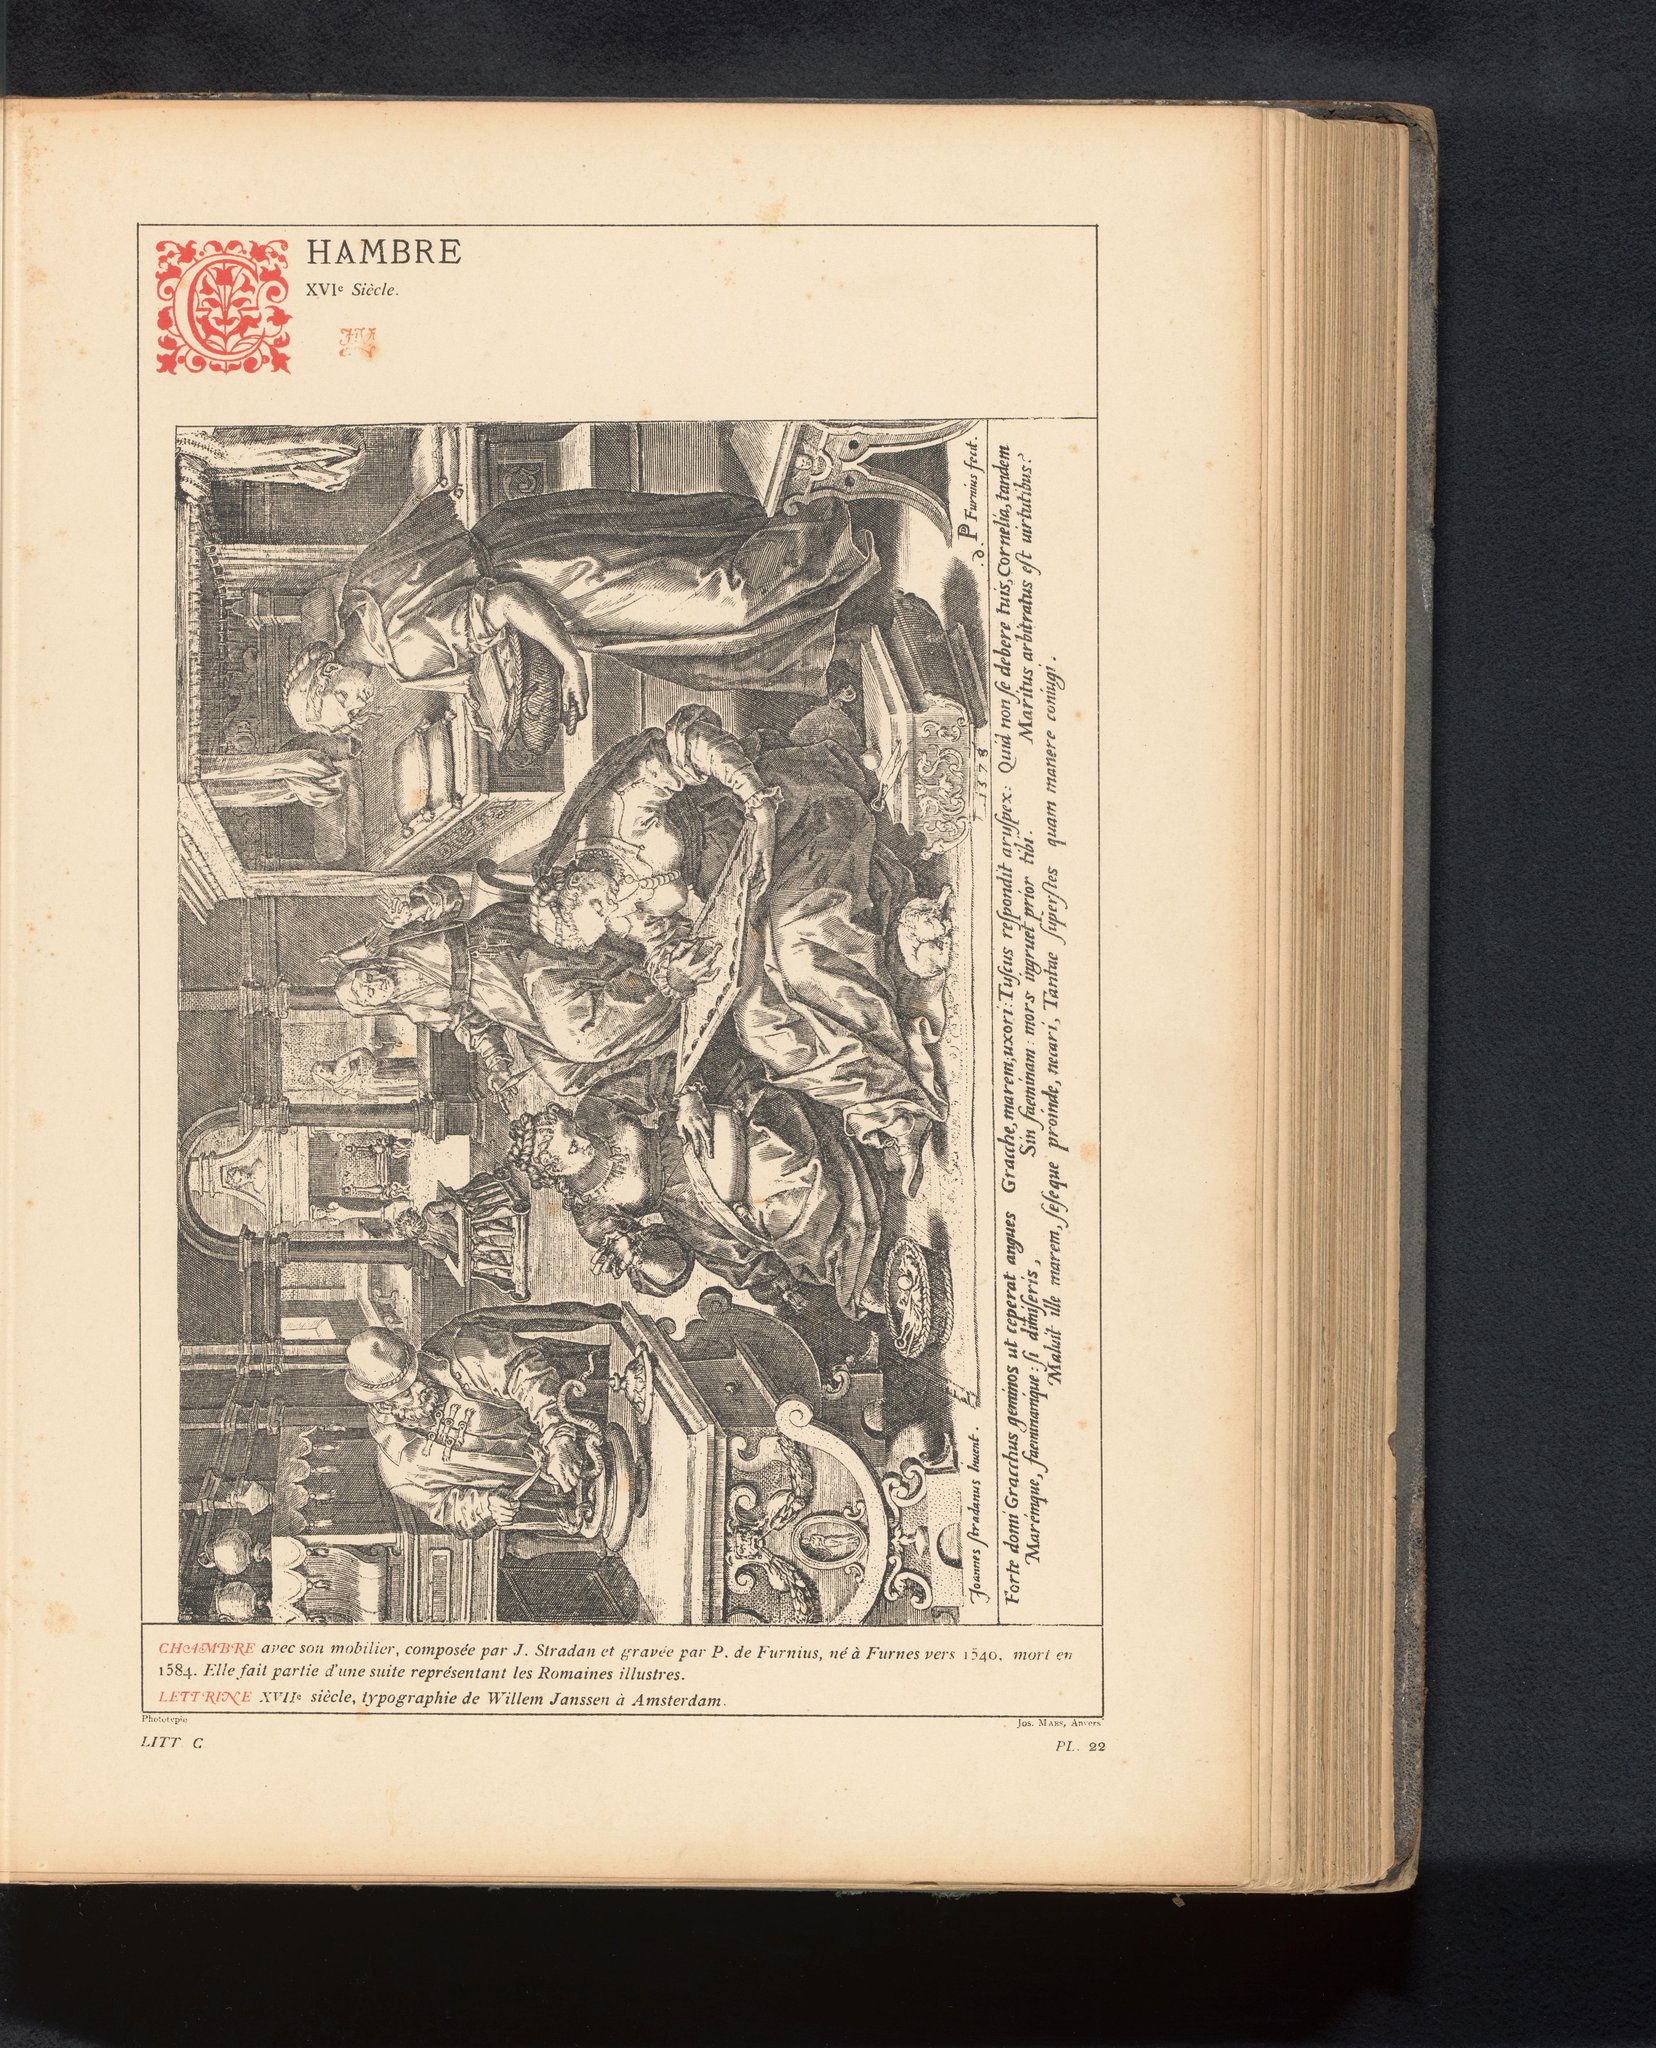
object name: reproduction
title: Reproductie van een prent van Cornelia en Gracchus binnenshuis door Pieter Jalhea Furnius naar Jan van der Straet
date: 1875-1880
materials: paper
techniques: photolithography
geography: antwerp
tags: (story of) tiberius sempronius gracchus, (story of) cornelia, mother of the gracchi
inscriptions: inscription: ‘Chambre avec son (...)’, inscription: ‘LITT: C. - PL. 22’, monogram: ‘JJvY’